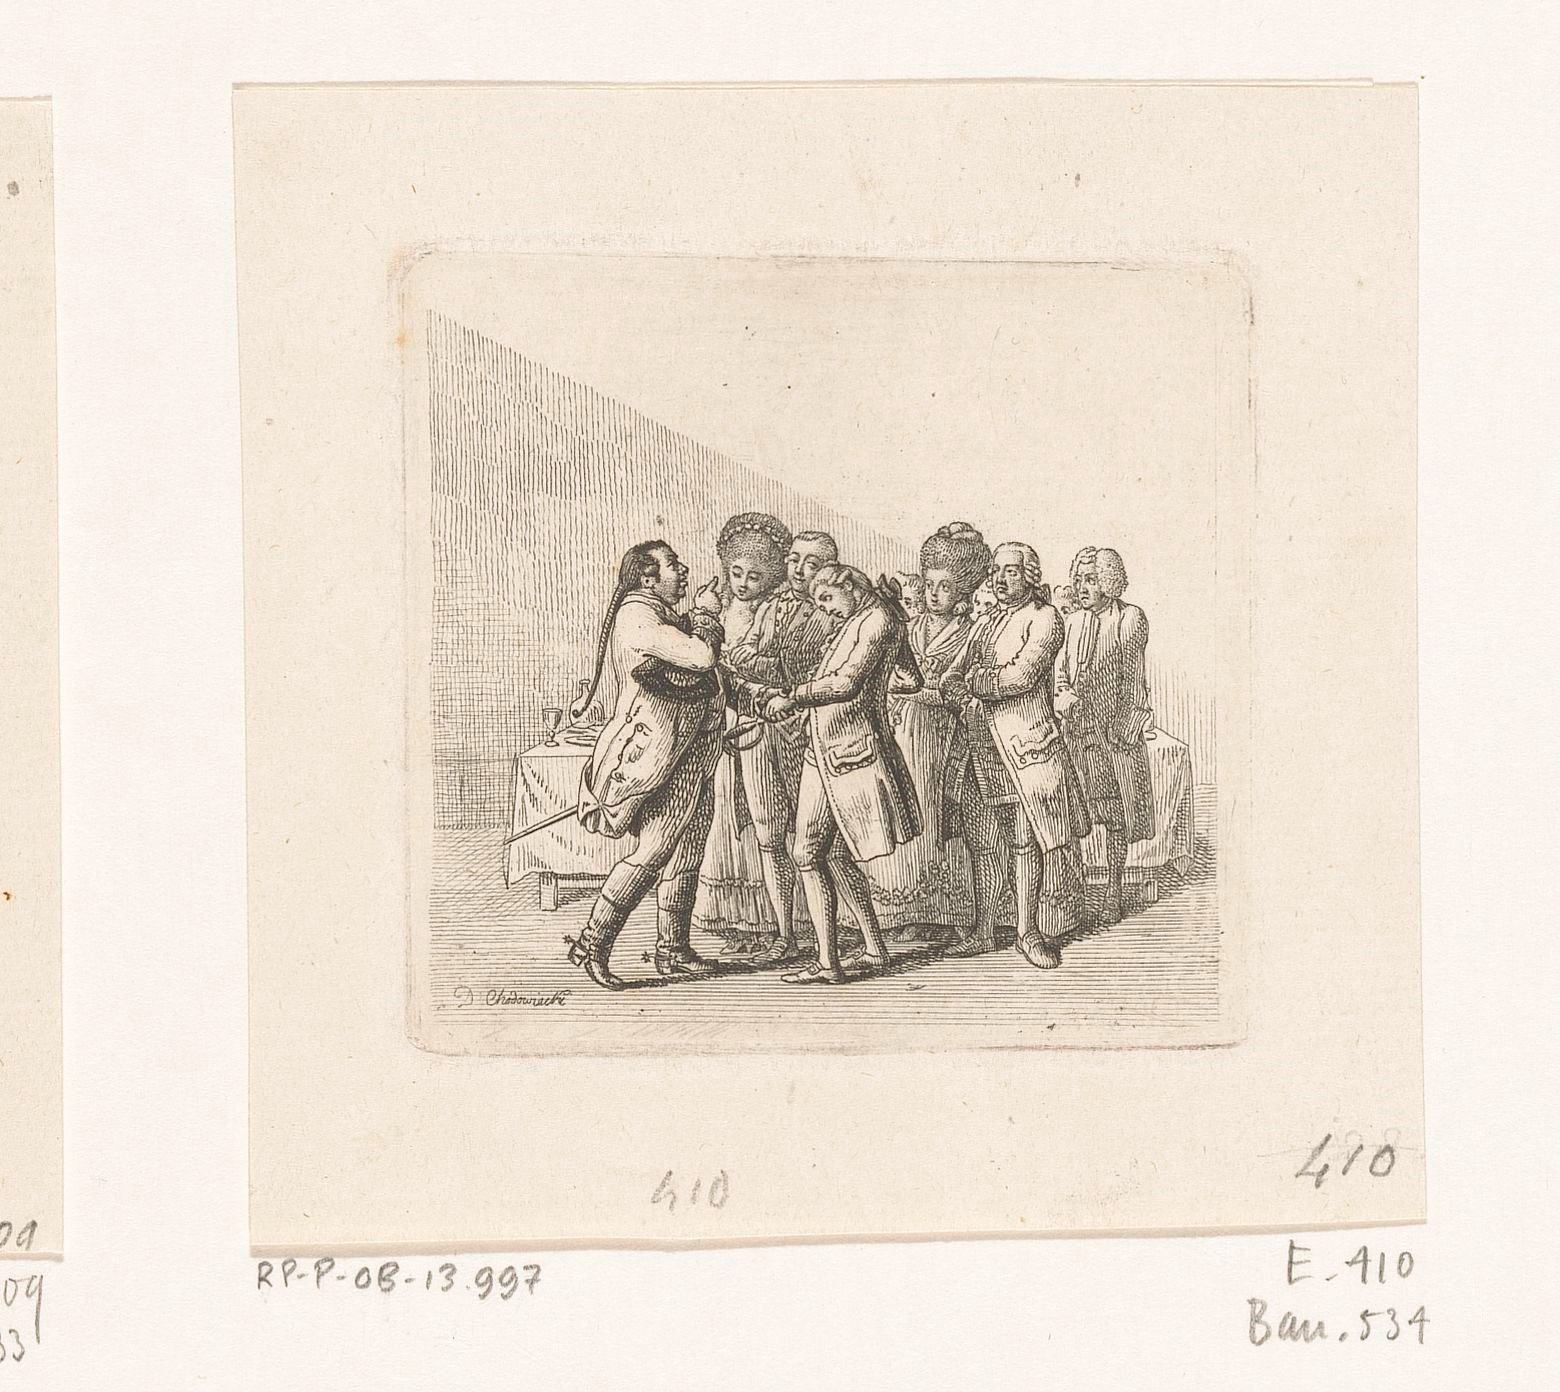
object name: print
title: Verlovingsfeest van Alexander en Tinchen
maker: daniel nikolaus chodowiecki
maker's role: draughtsman, print maker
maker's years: 1726-1801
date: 1781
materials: paper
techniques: etching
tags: literature, betrothal, private festivities, merry company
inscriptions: collector's mark: Lugt 2228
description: Alexander heeft zich verloofd met Lorchen die zich inmiddels Tinchen noemt. Herr von Weesen schudt de hand van jonker Gotthard. Naast hen staat het bruidspaar. Als gevolg van zijn militaire carrière in Russische dienst heeft Alexander nog maar een arm.